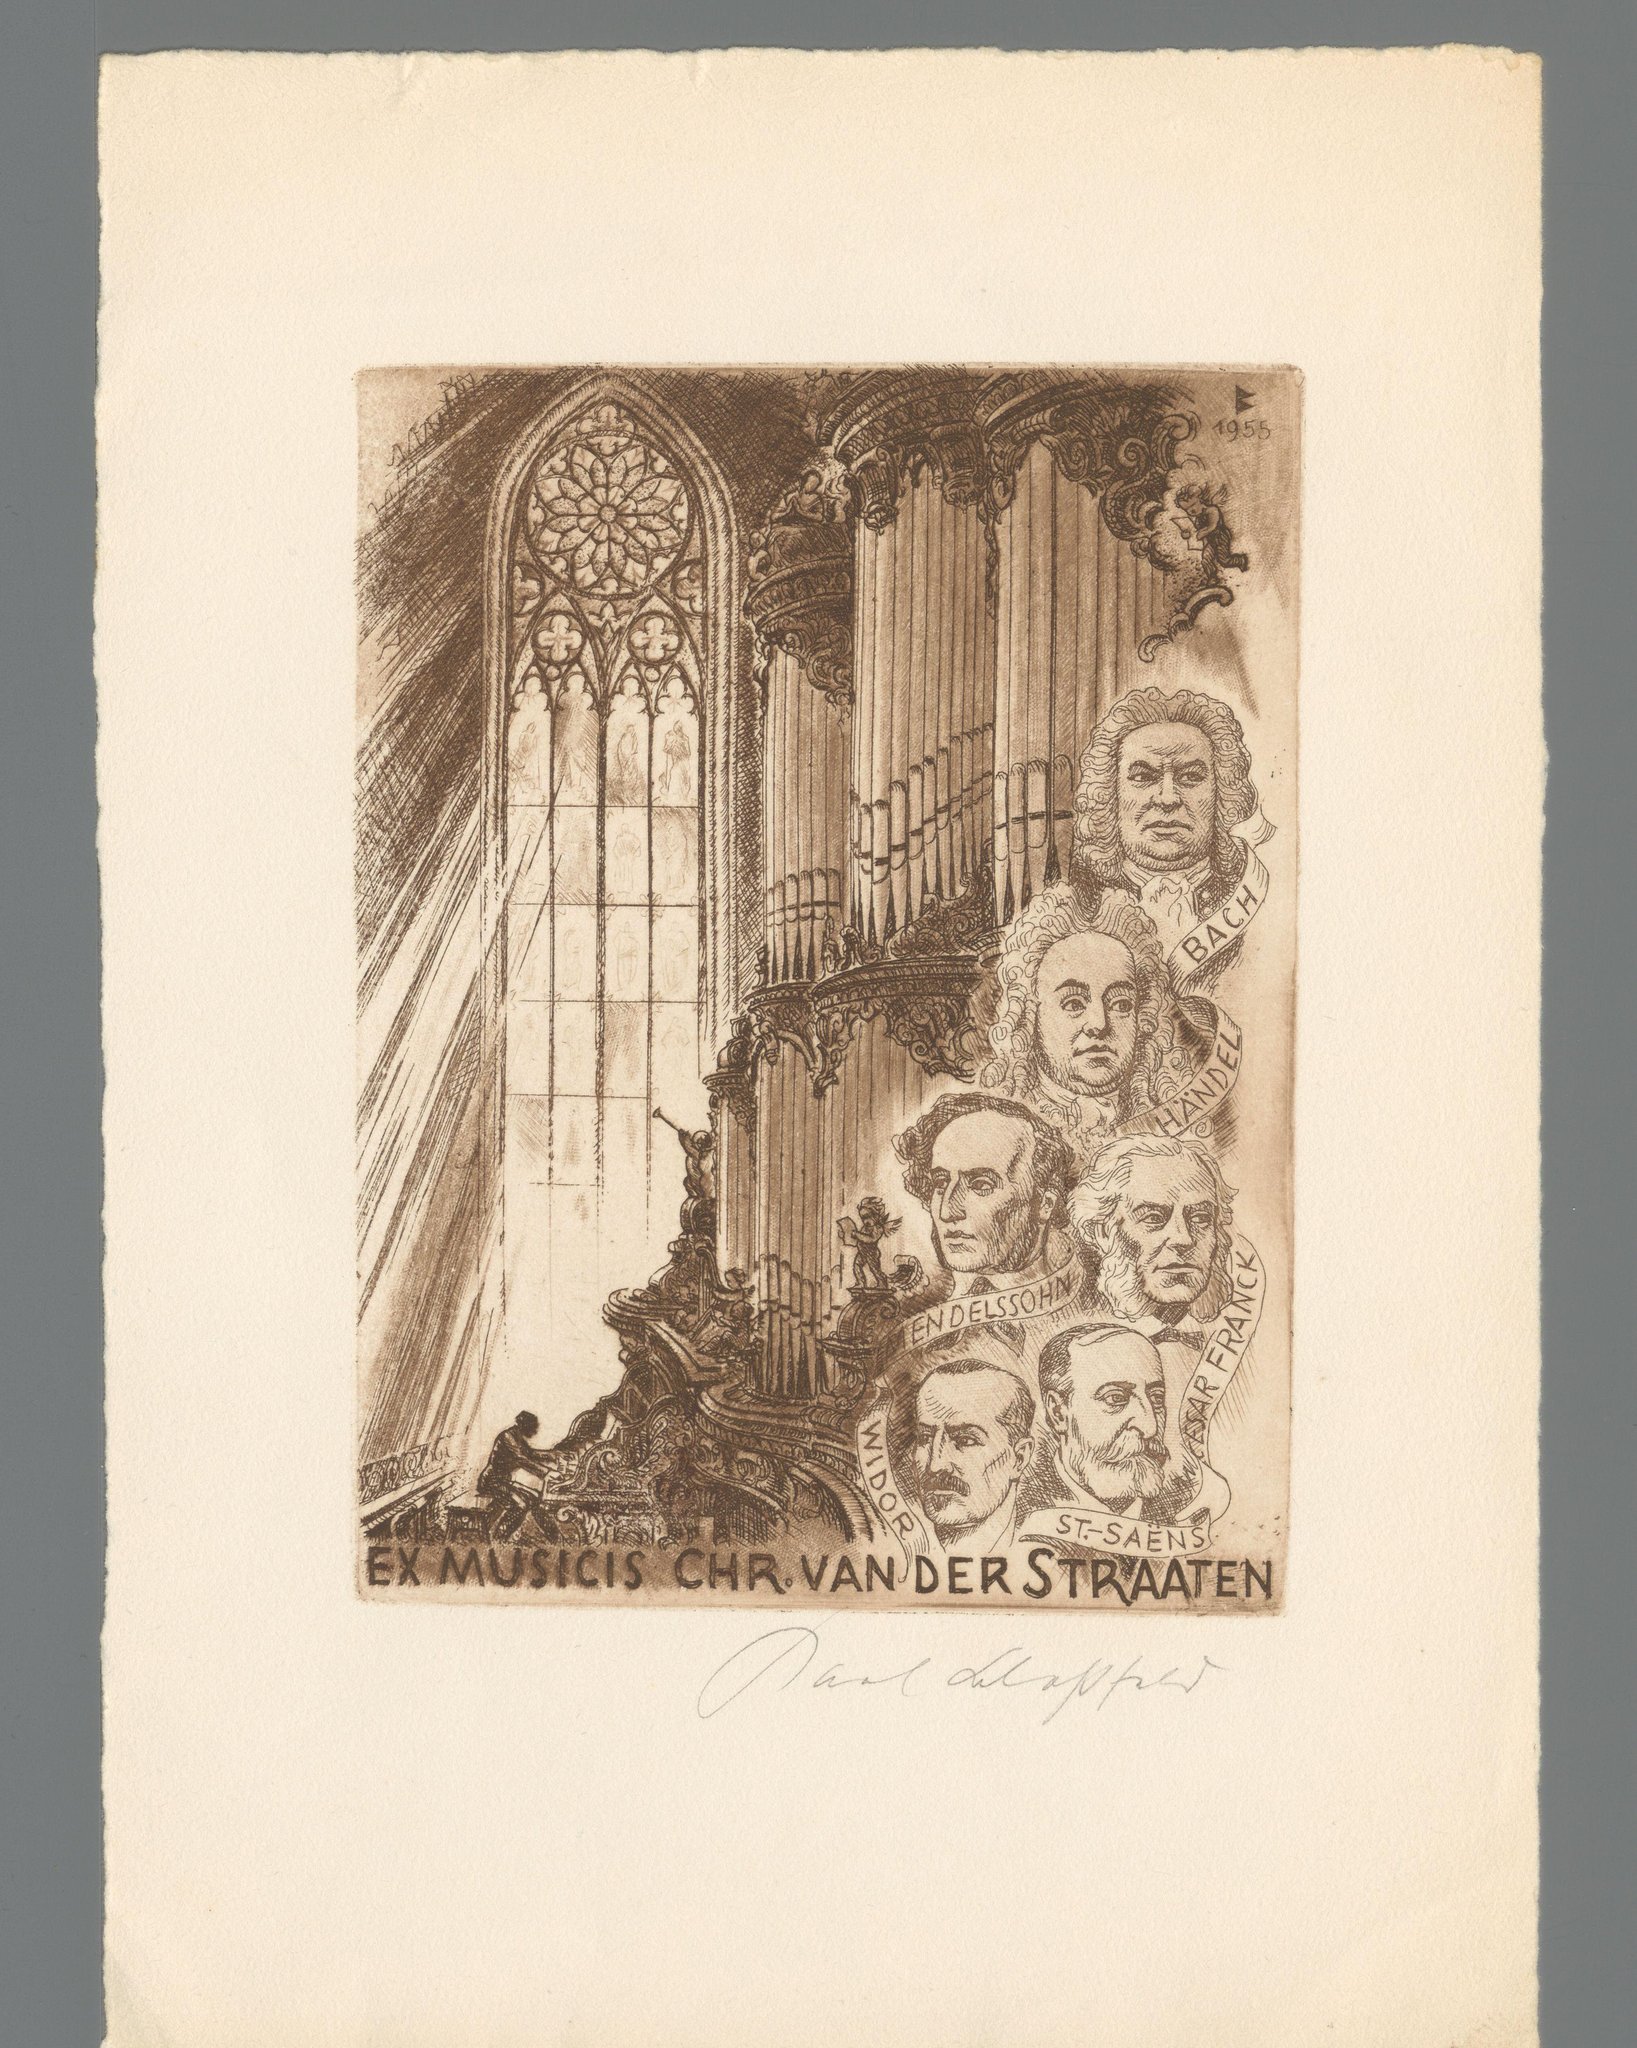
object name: bookplate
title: Ex libris van Chris van der Straaten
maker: karl blossfeld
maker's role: print maker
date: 1955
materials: paper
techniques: drypoint, etching, intaglio, roulette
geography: germany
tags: london, church-window, e.g. rose-window, historical persons, church organ, composer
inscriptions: signature: ‘Paul [...]pper [?]’, inscription: ‘Karl Blossfeld’